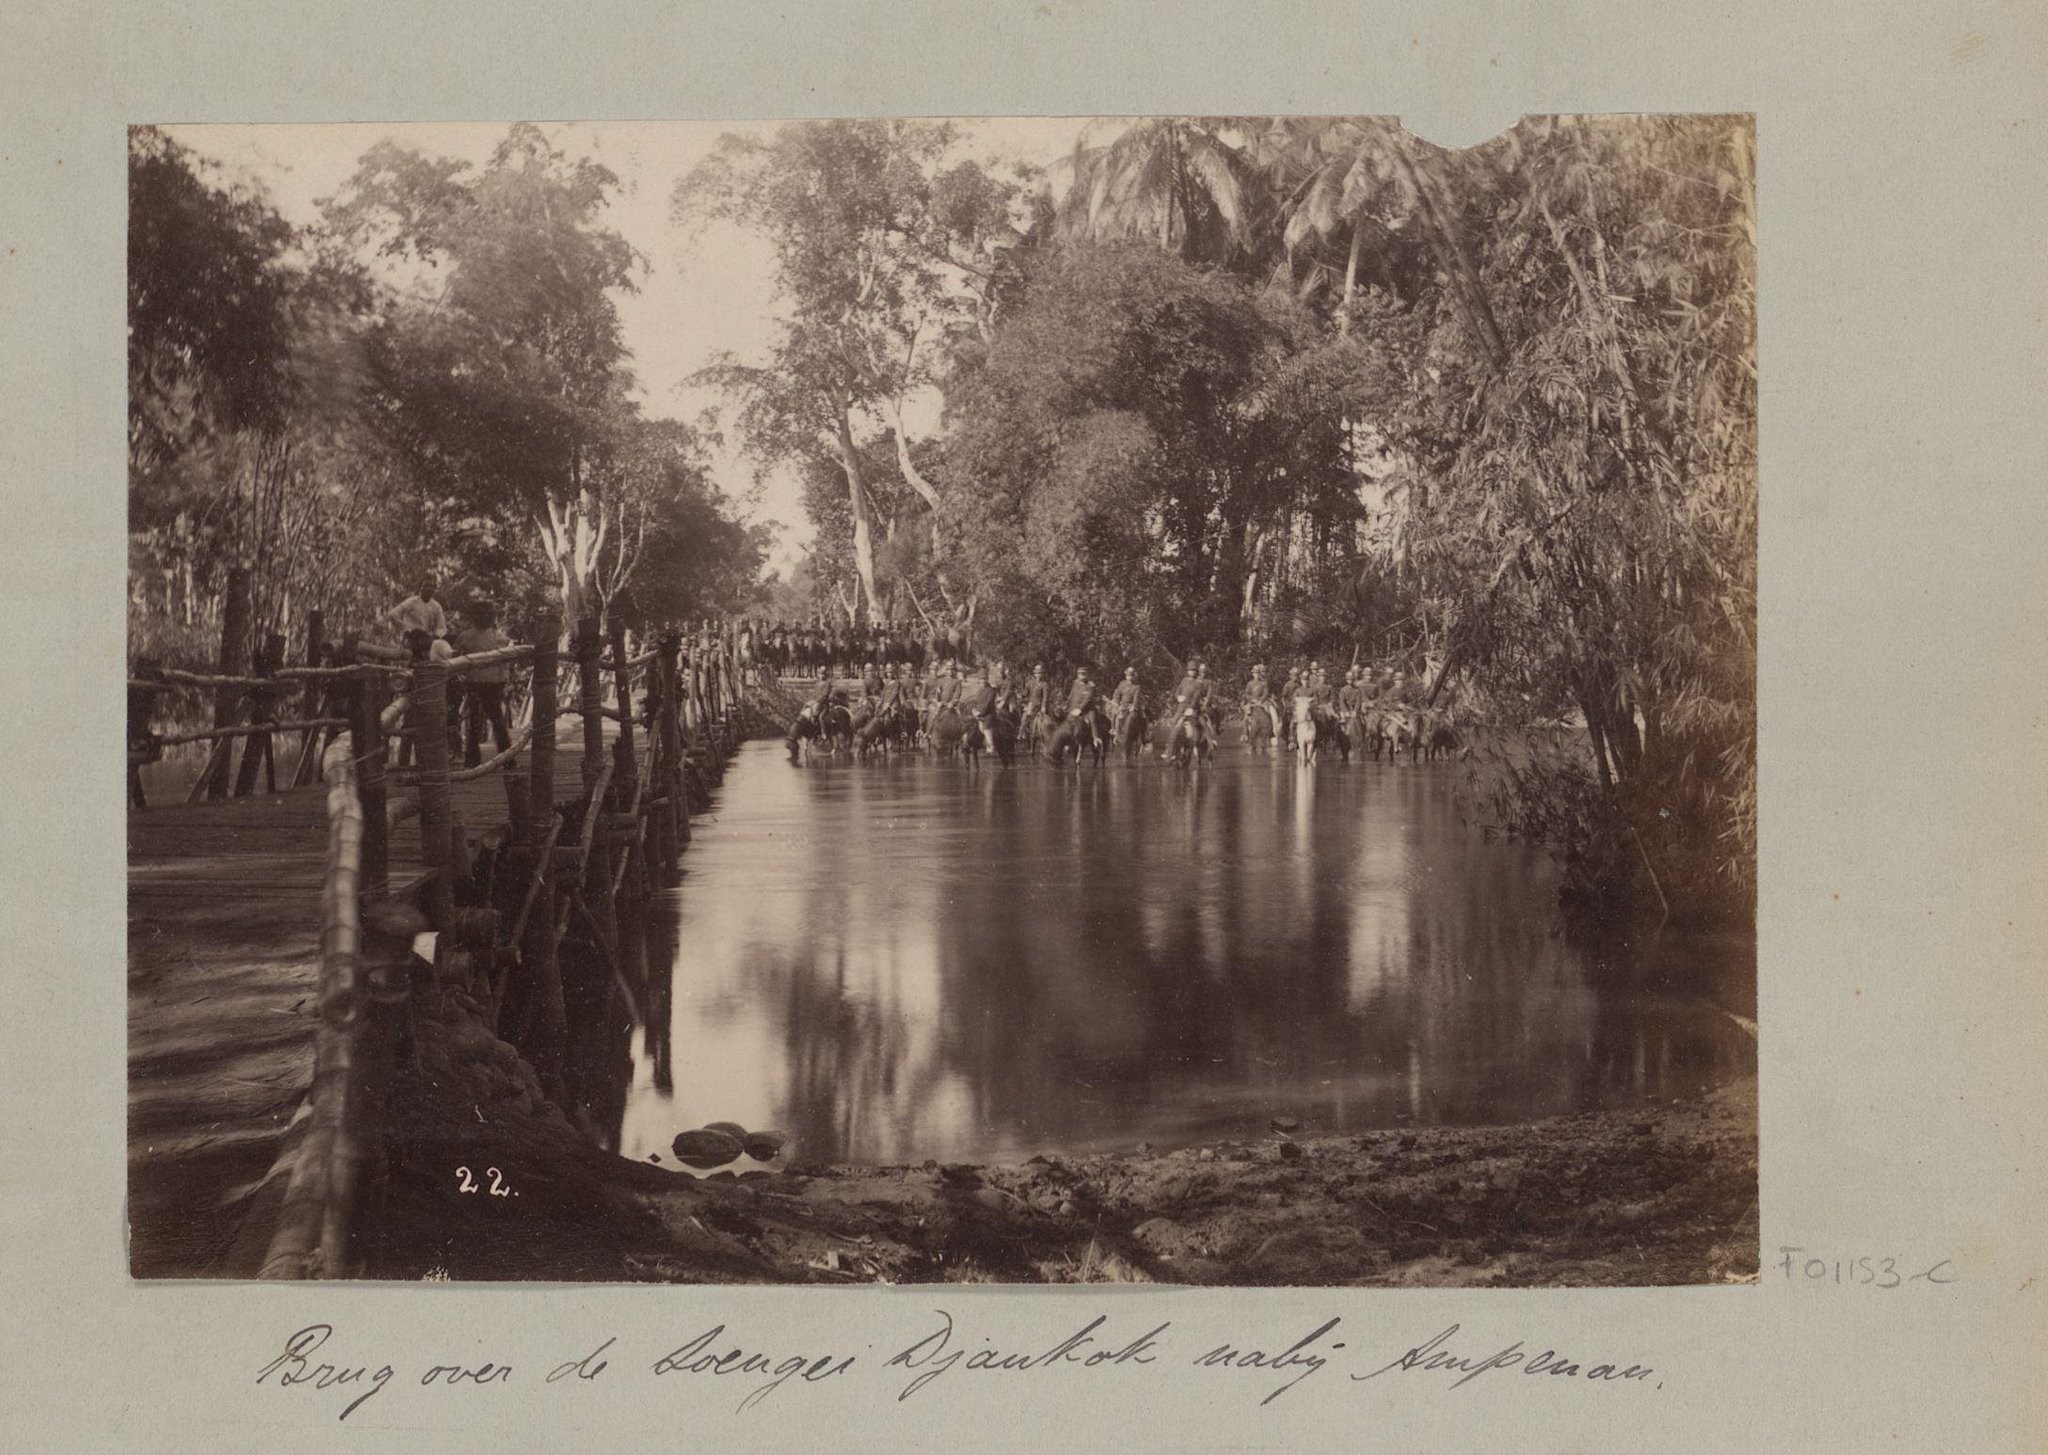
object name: photograph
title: Brug over de Soengei Djankok nabij Ampenan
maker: christiaan johan neeb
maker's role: arts, fotograaf, officier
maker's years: 1860-1925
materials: photographic support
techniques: albumen print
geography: lombok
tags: the company, the unit, the troop ~ military service, landscapes with waters, waterscapes, seascapes (in the temperate zone), bridge, dutch east indies, the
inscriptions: number: ‘22’